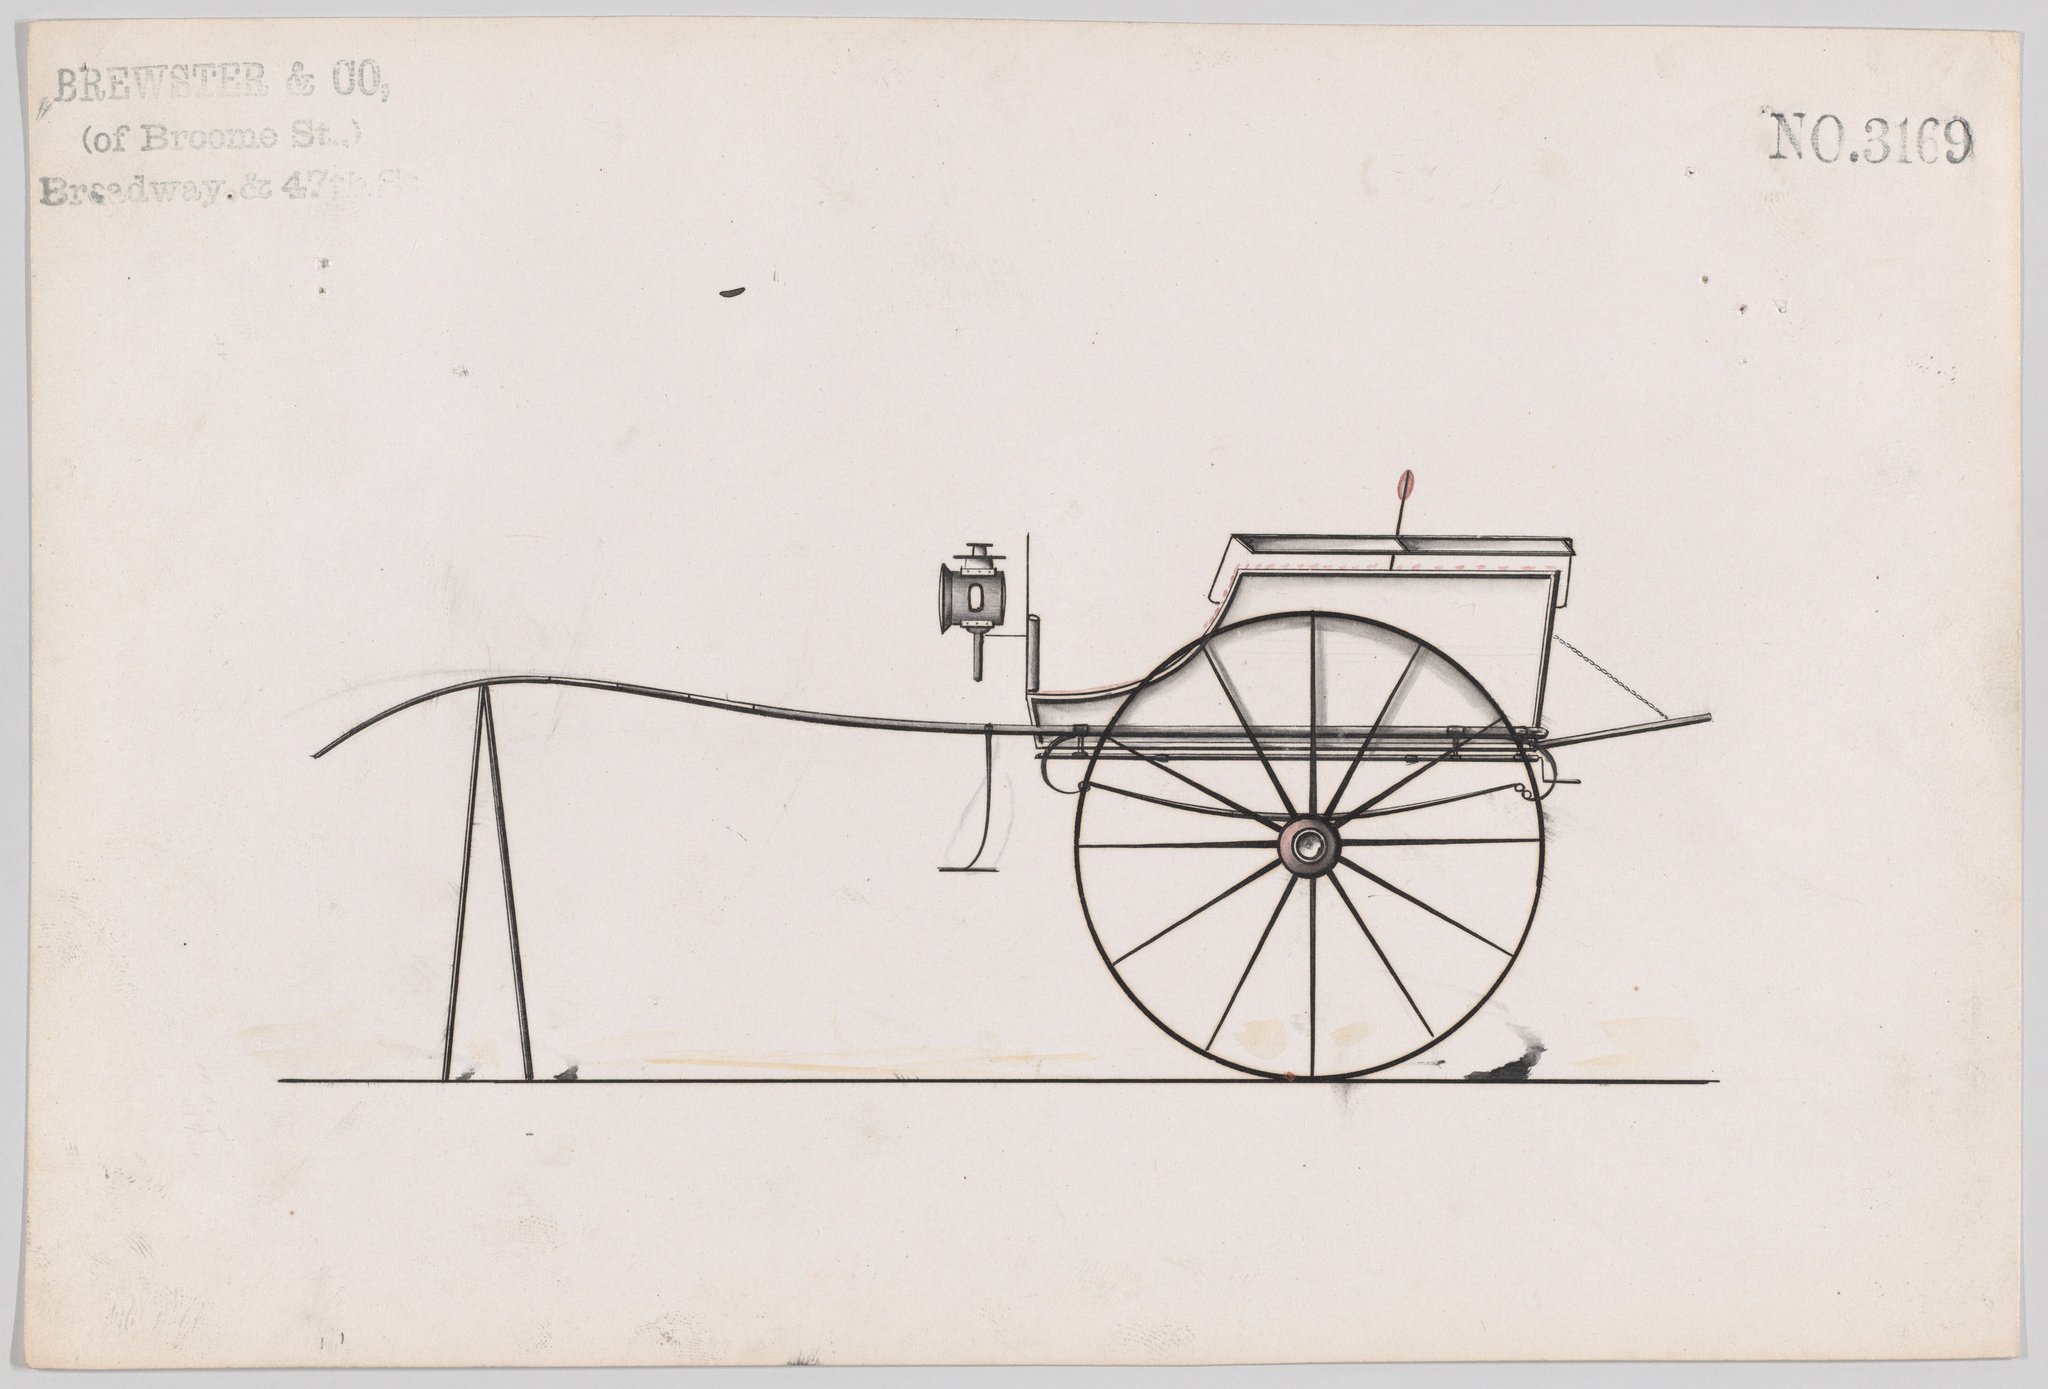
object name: drawing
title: Dog Cart # 3169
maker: brewster & co.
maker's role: manufacturer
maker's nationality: american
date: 1875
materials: gouache, gum arabic, ink, watercolor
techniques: pen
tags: carriages